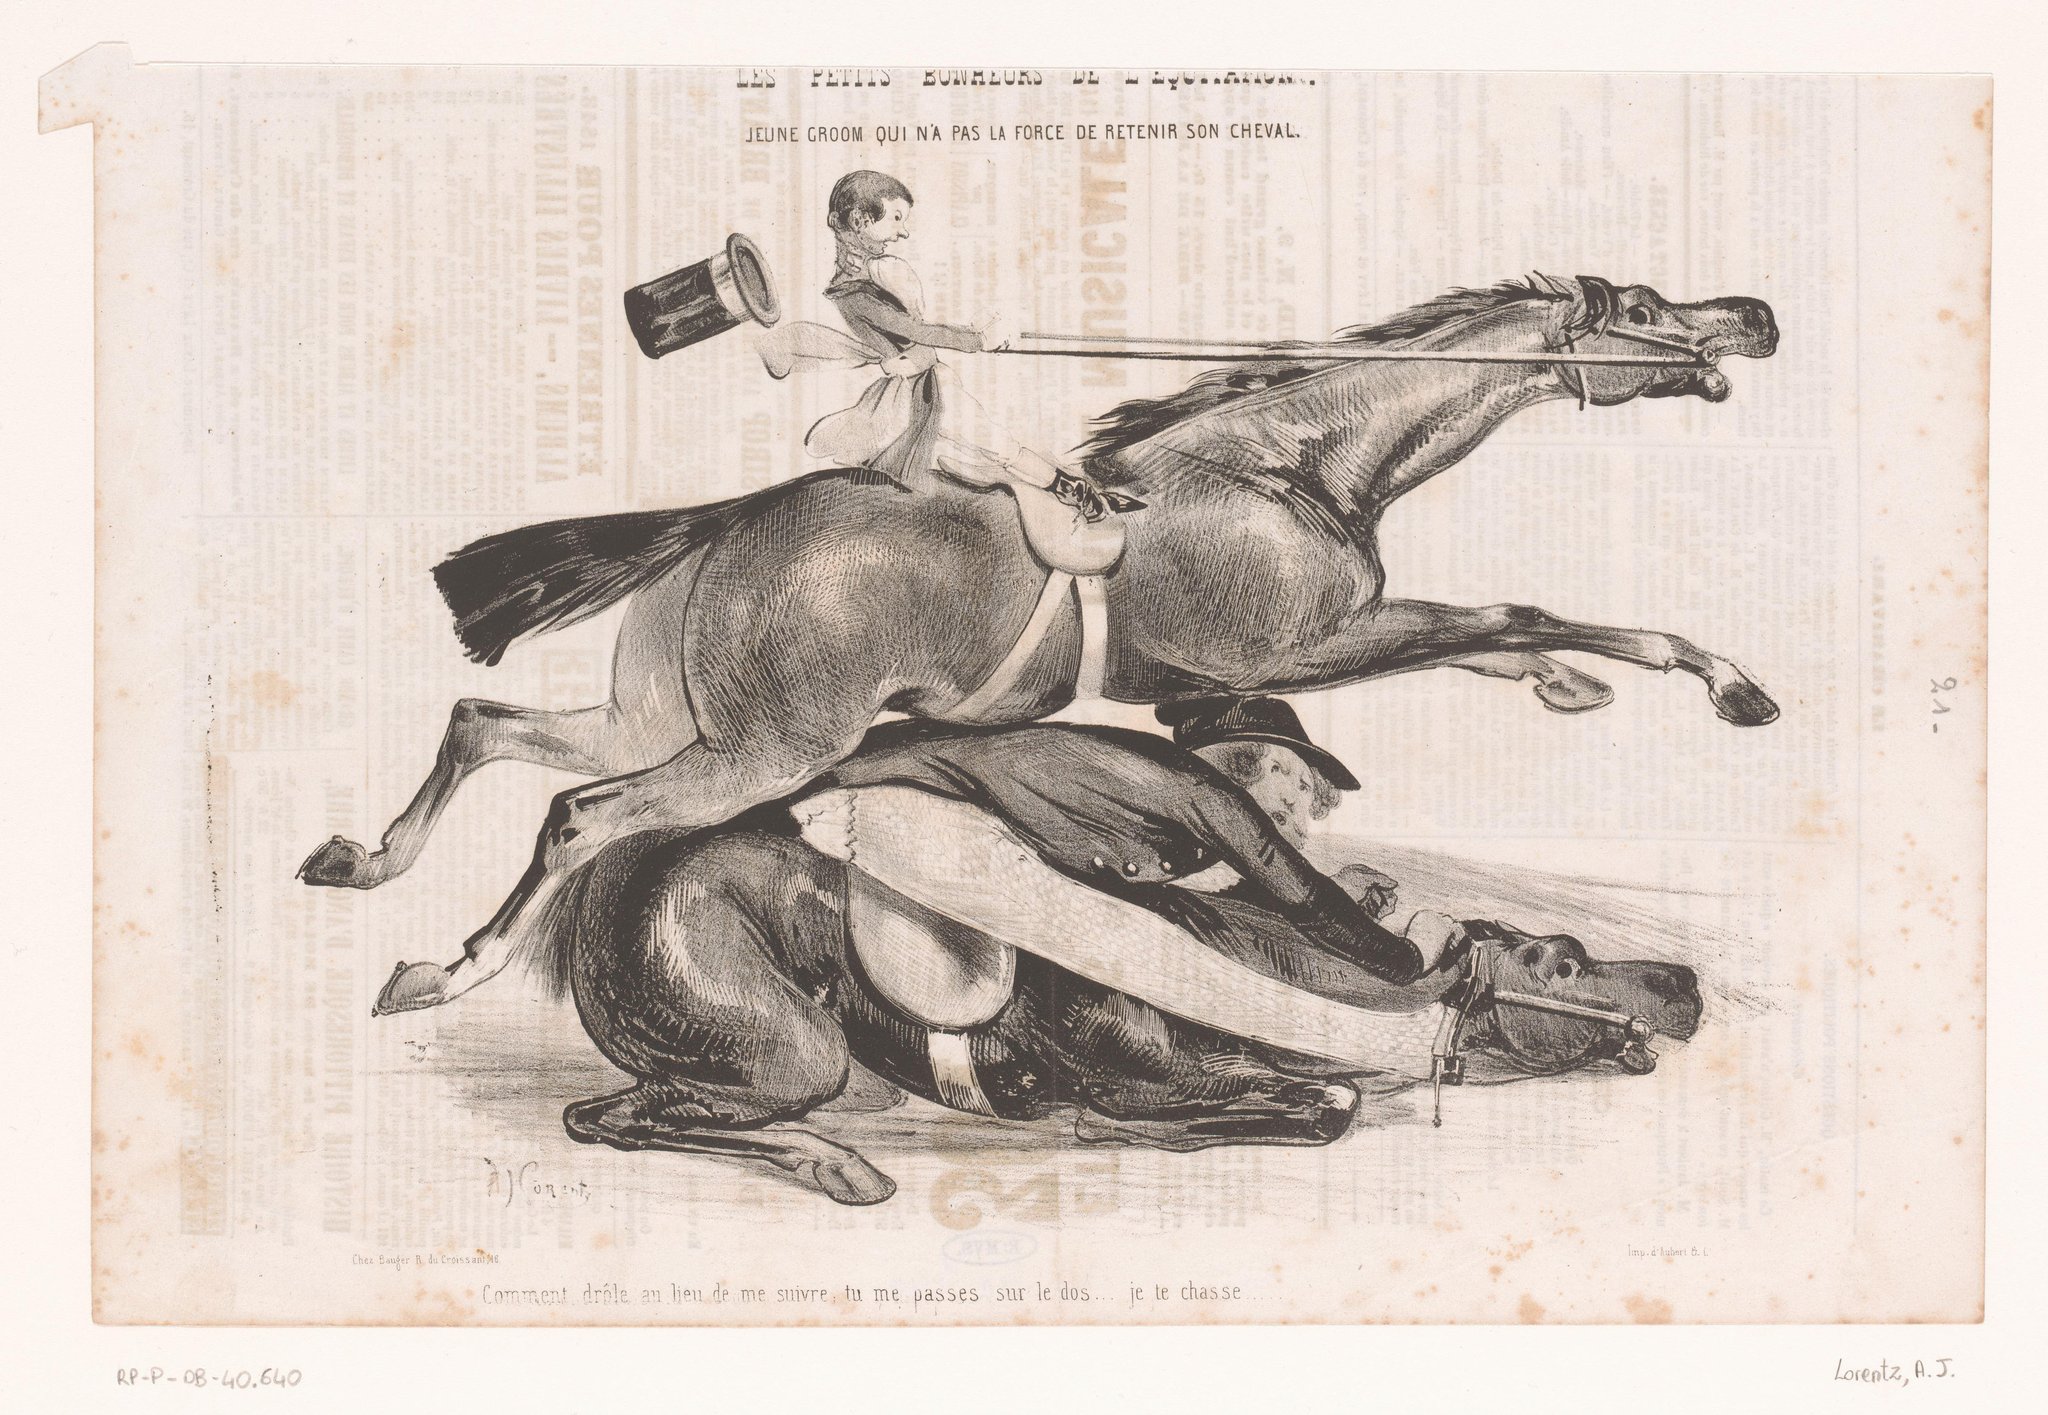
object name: cartoon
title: Kleine geneugten van het paardrijden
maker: alcide joseph lorentz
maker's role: print maker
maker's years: 1813-1889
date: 1842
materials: paper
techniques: letterpress printing, lithograph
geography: paris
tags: riding a horse, ass, or mule; rider, horseman, caricatures (human types)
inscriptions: collector's mark: Lugt 2228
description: Prent uit: Le Charivari 11 (1842), nr. 341, 7 december 1842. Serienummer is afgesneden, maar prent maakt deel uit van een serie van acht prenten waarvan dit de zevende is.